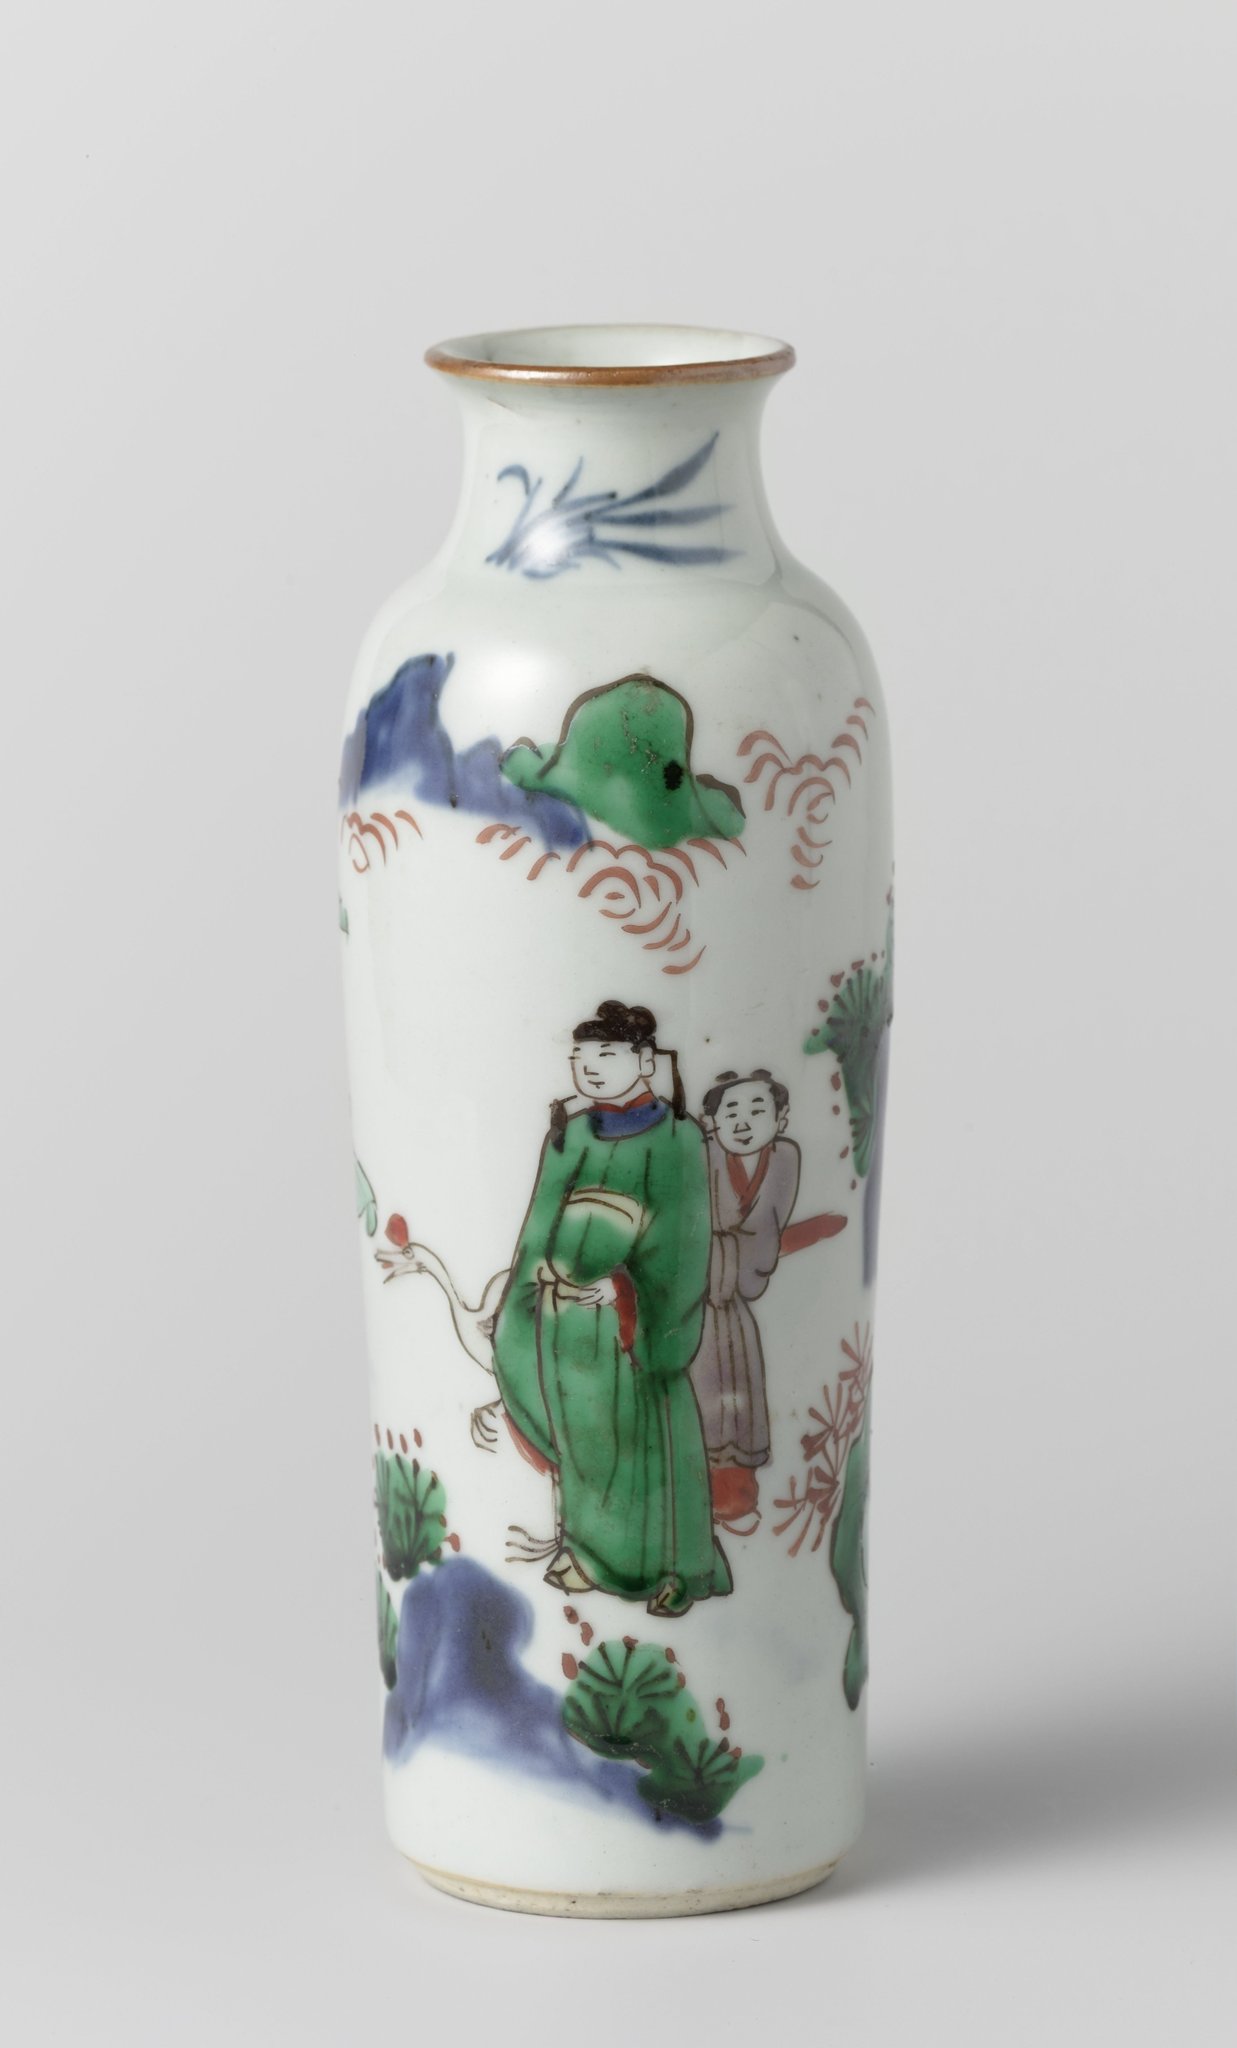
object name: vase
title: Vase (rolwagen) with a scholar-official and his servant in a landscape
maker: Anonymous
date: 1645-1660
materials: cobalt, glaze, paint, porcelain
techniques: firing, turning, vitrification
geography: china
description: Kleine cilindrische vaas (rolwagen) van porselein met een spreidende hals, beschilderd in onderglazuur blauw en op het glazuur rood, groen, geel, aubergine en zwart. Op de wand een hoogwaardigheidsbekleder en zijn bediende in een landschap met planten, een bananenplant, rotsen en bergen. Naast de twee mannen staat een kraanvogel. Op de hals tweemaal een plant. De onderzijde is ongeglazuurd. Overgangsporselein met emailkleuren.